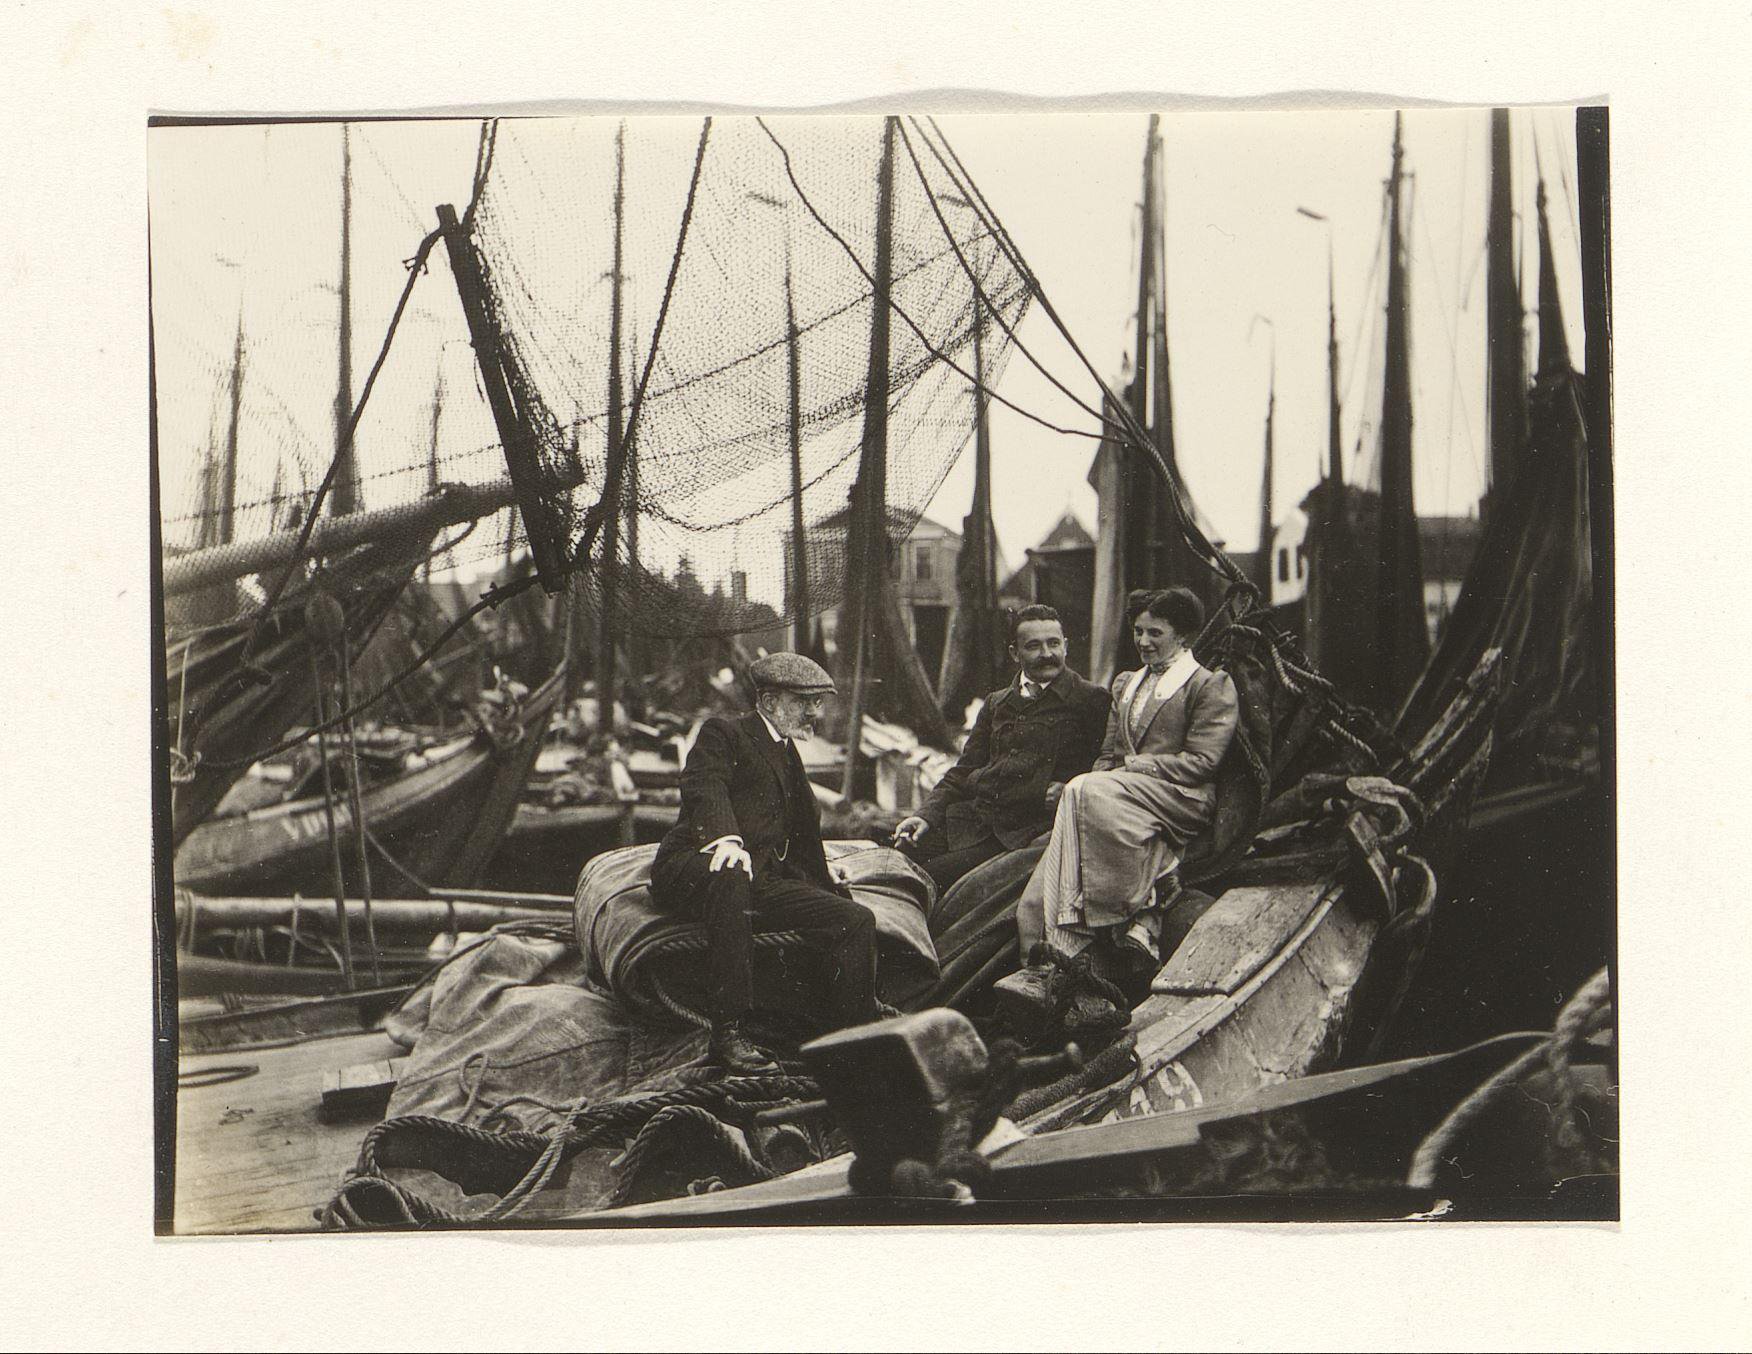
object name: photograph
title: Mannen en vrouw op een boot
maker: george hidderley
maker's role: fotograaf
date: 1900-1910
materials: paper, photographic support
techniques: gelatin silver print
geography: volendam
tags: adult woman, adult man, historical persons, ships (in general)